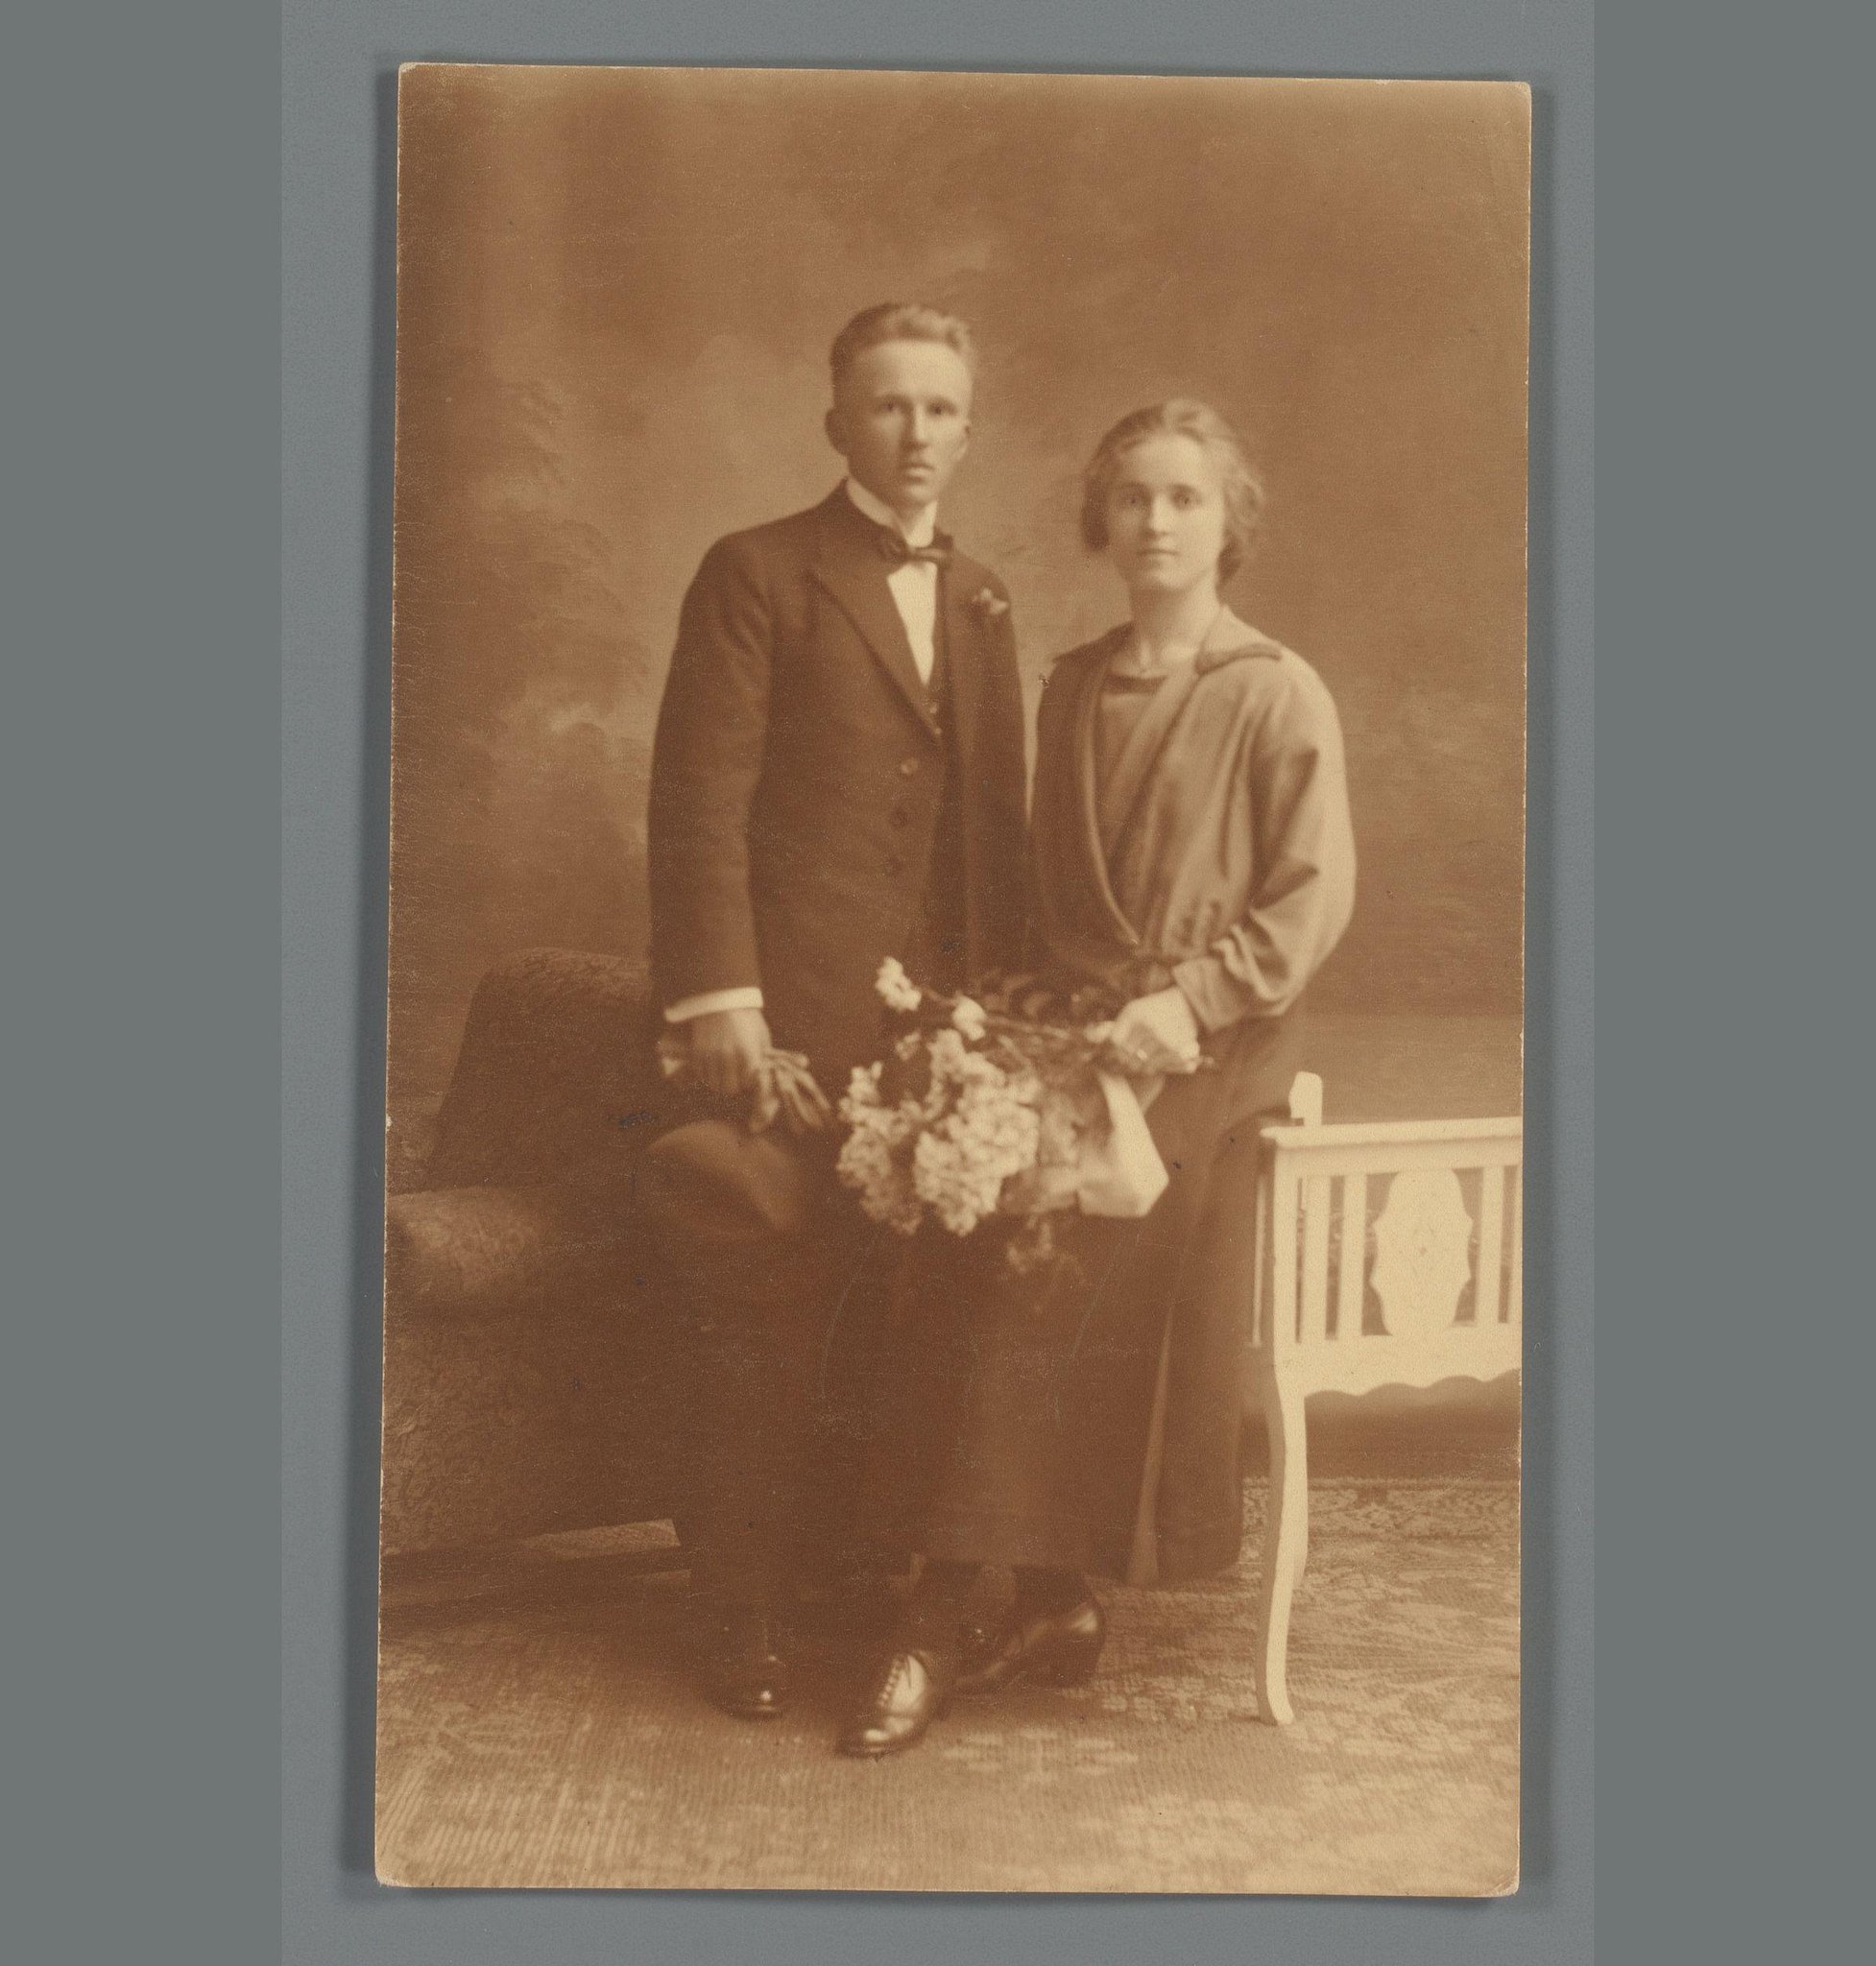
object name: ansichtkaart, prentbriefkaart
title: Portret van een onbekende jongeman en vrouw in een fotostudio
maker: Anonymous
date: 1905-1920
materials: paper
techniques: gelatin silver print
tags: couple of lovers, historical persons not known by name